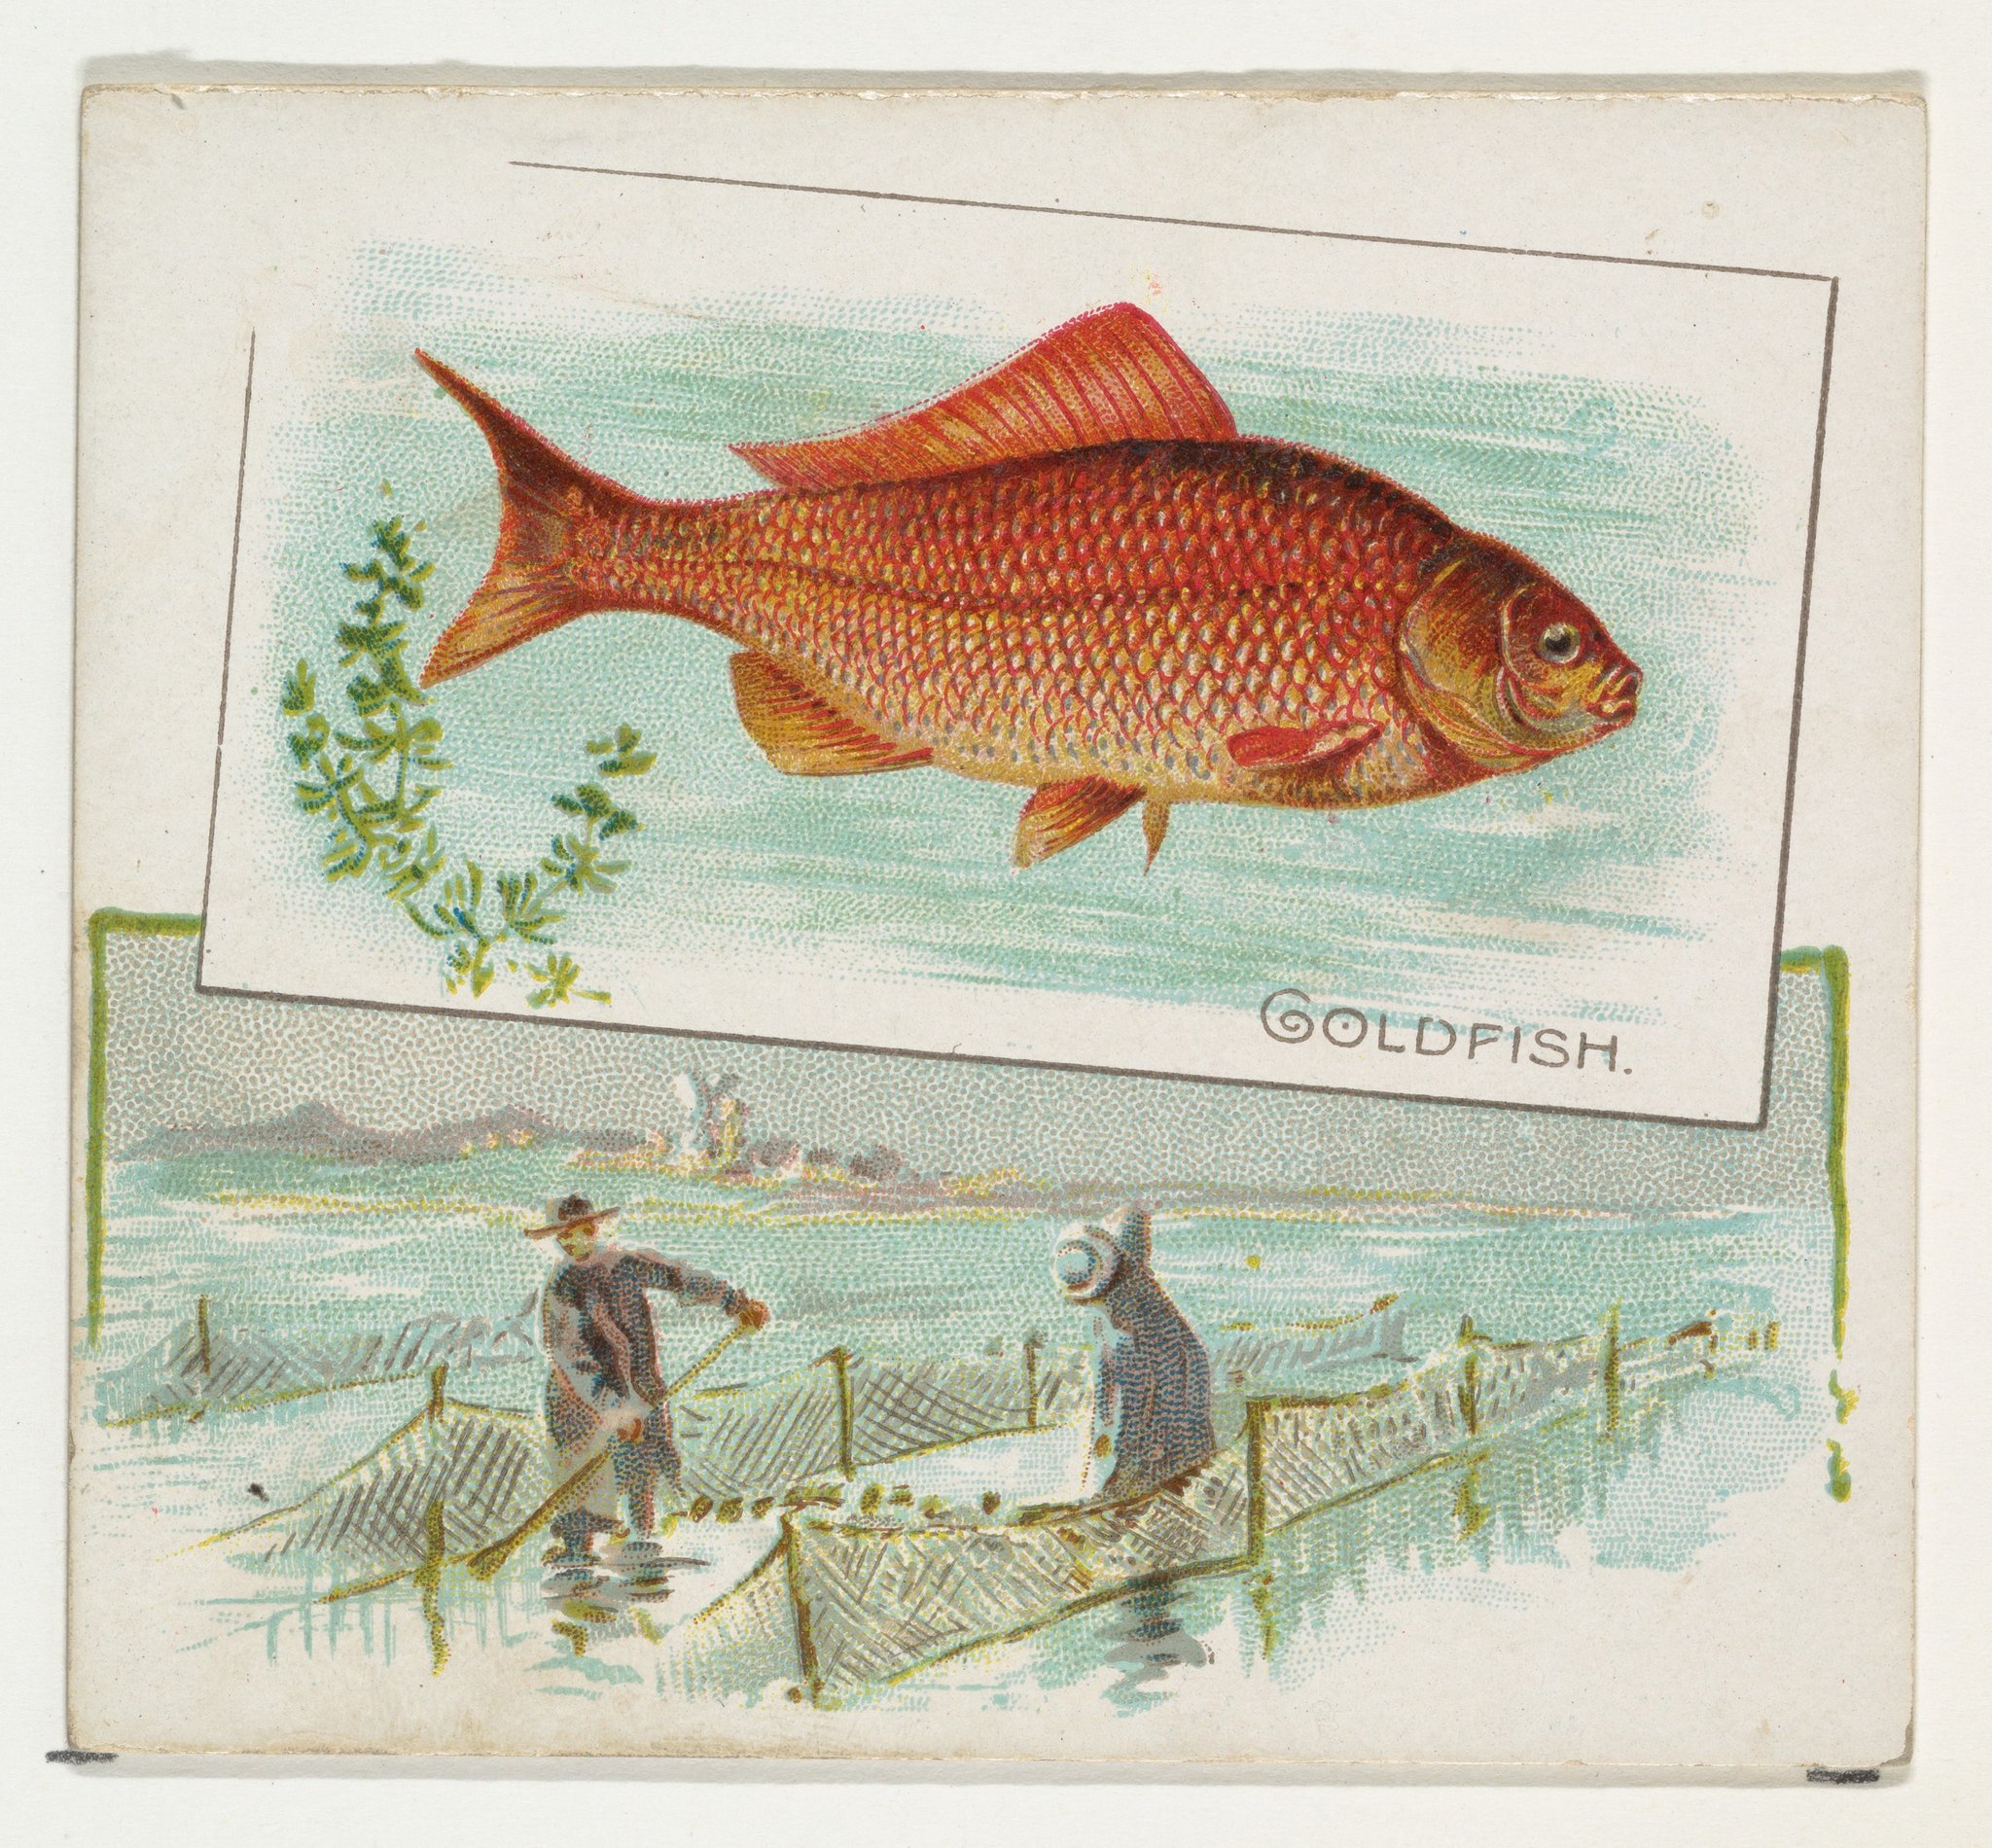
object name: print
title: Goldfish, from Fish from American Waters series (N39) for Allen & Ginter Cigarettes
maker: allen & ginter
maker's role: publisher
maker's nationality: american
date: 1889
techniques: color lithograph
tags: fish